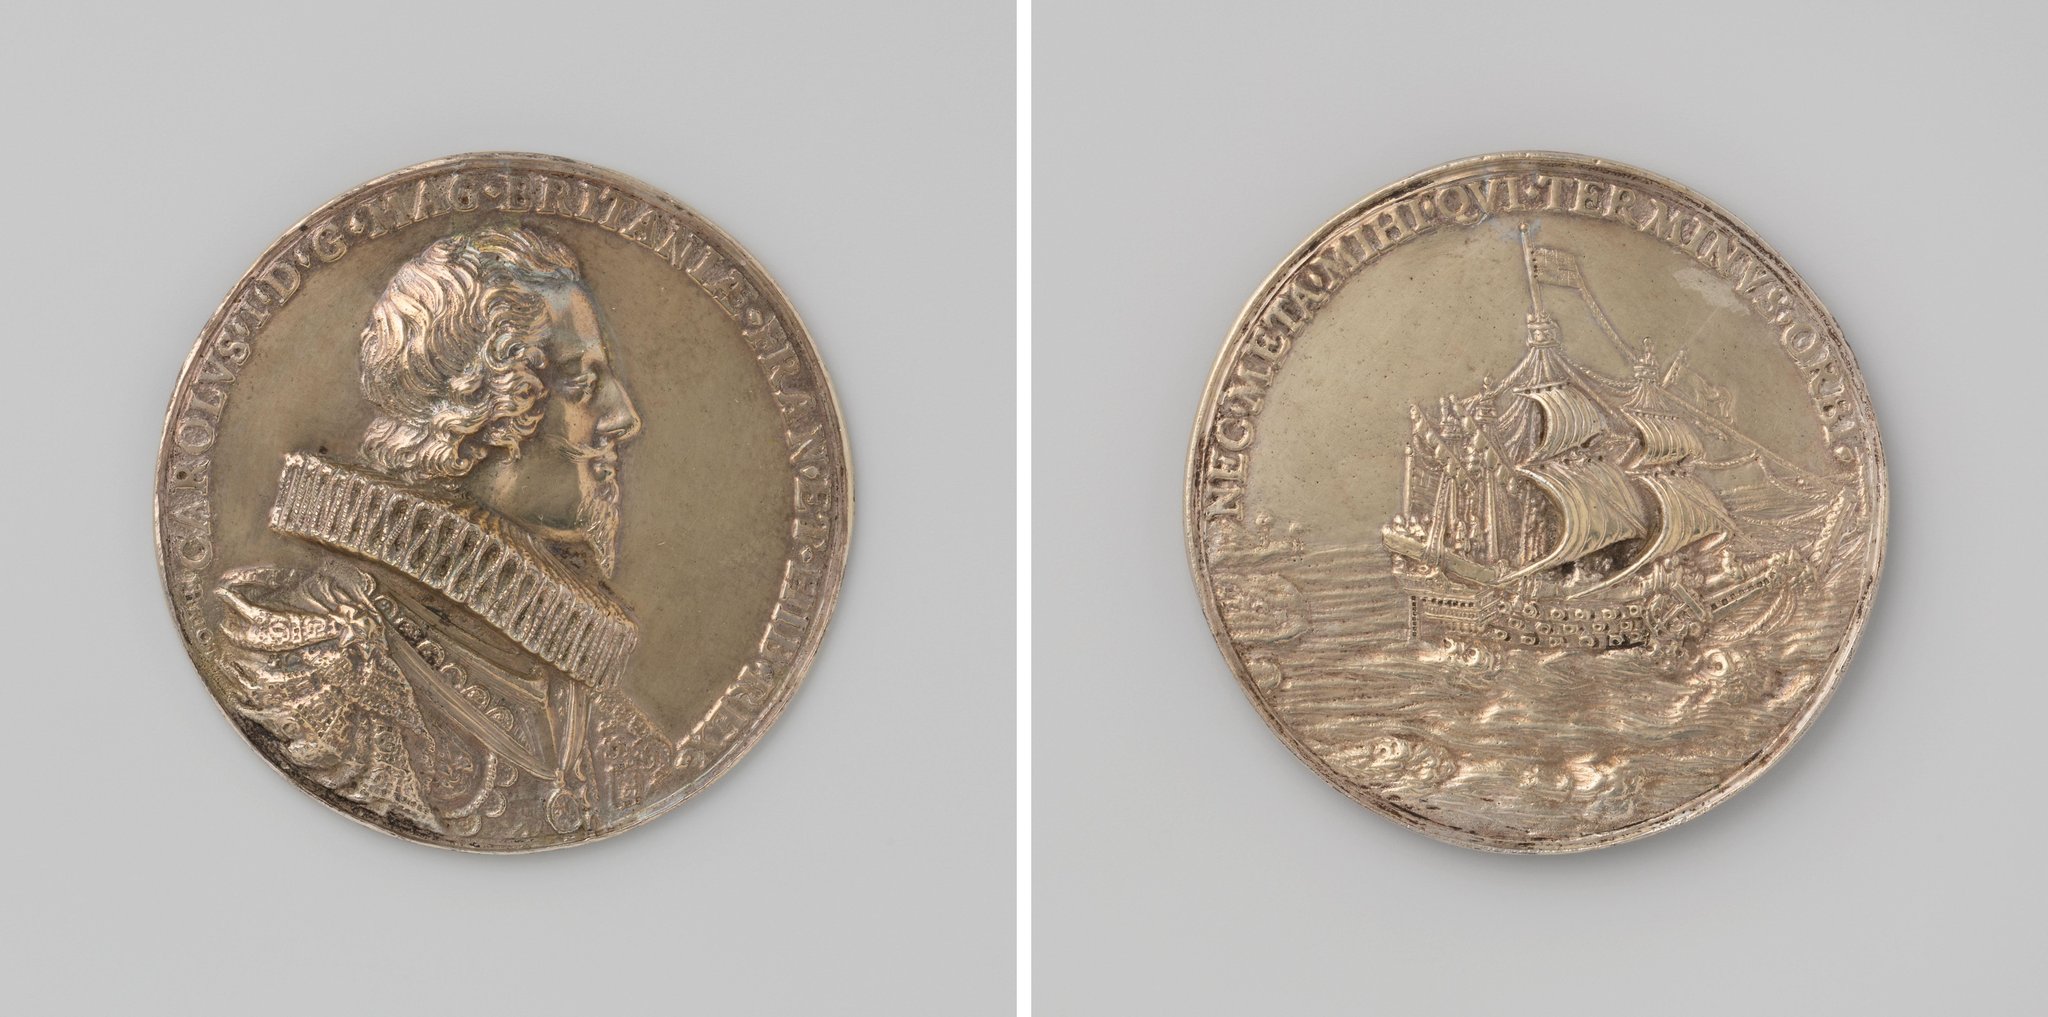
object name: history medal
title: Geschillen met Karel I van Engeland over de heerschappij over de zee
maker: nicolas briot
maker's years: 1579-1646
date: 1630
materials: silver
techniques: casting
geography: london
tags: london, karel i (koning van engeland)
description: Zilveren penning. Voorzijde: borststuk man binnen omschrift. Keerzijde: schip op zee binnen omschrift.